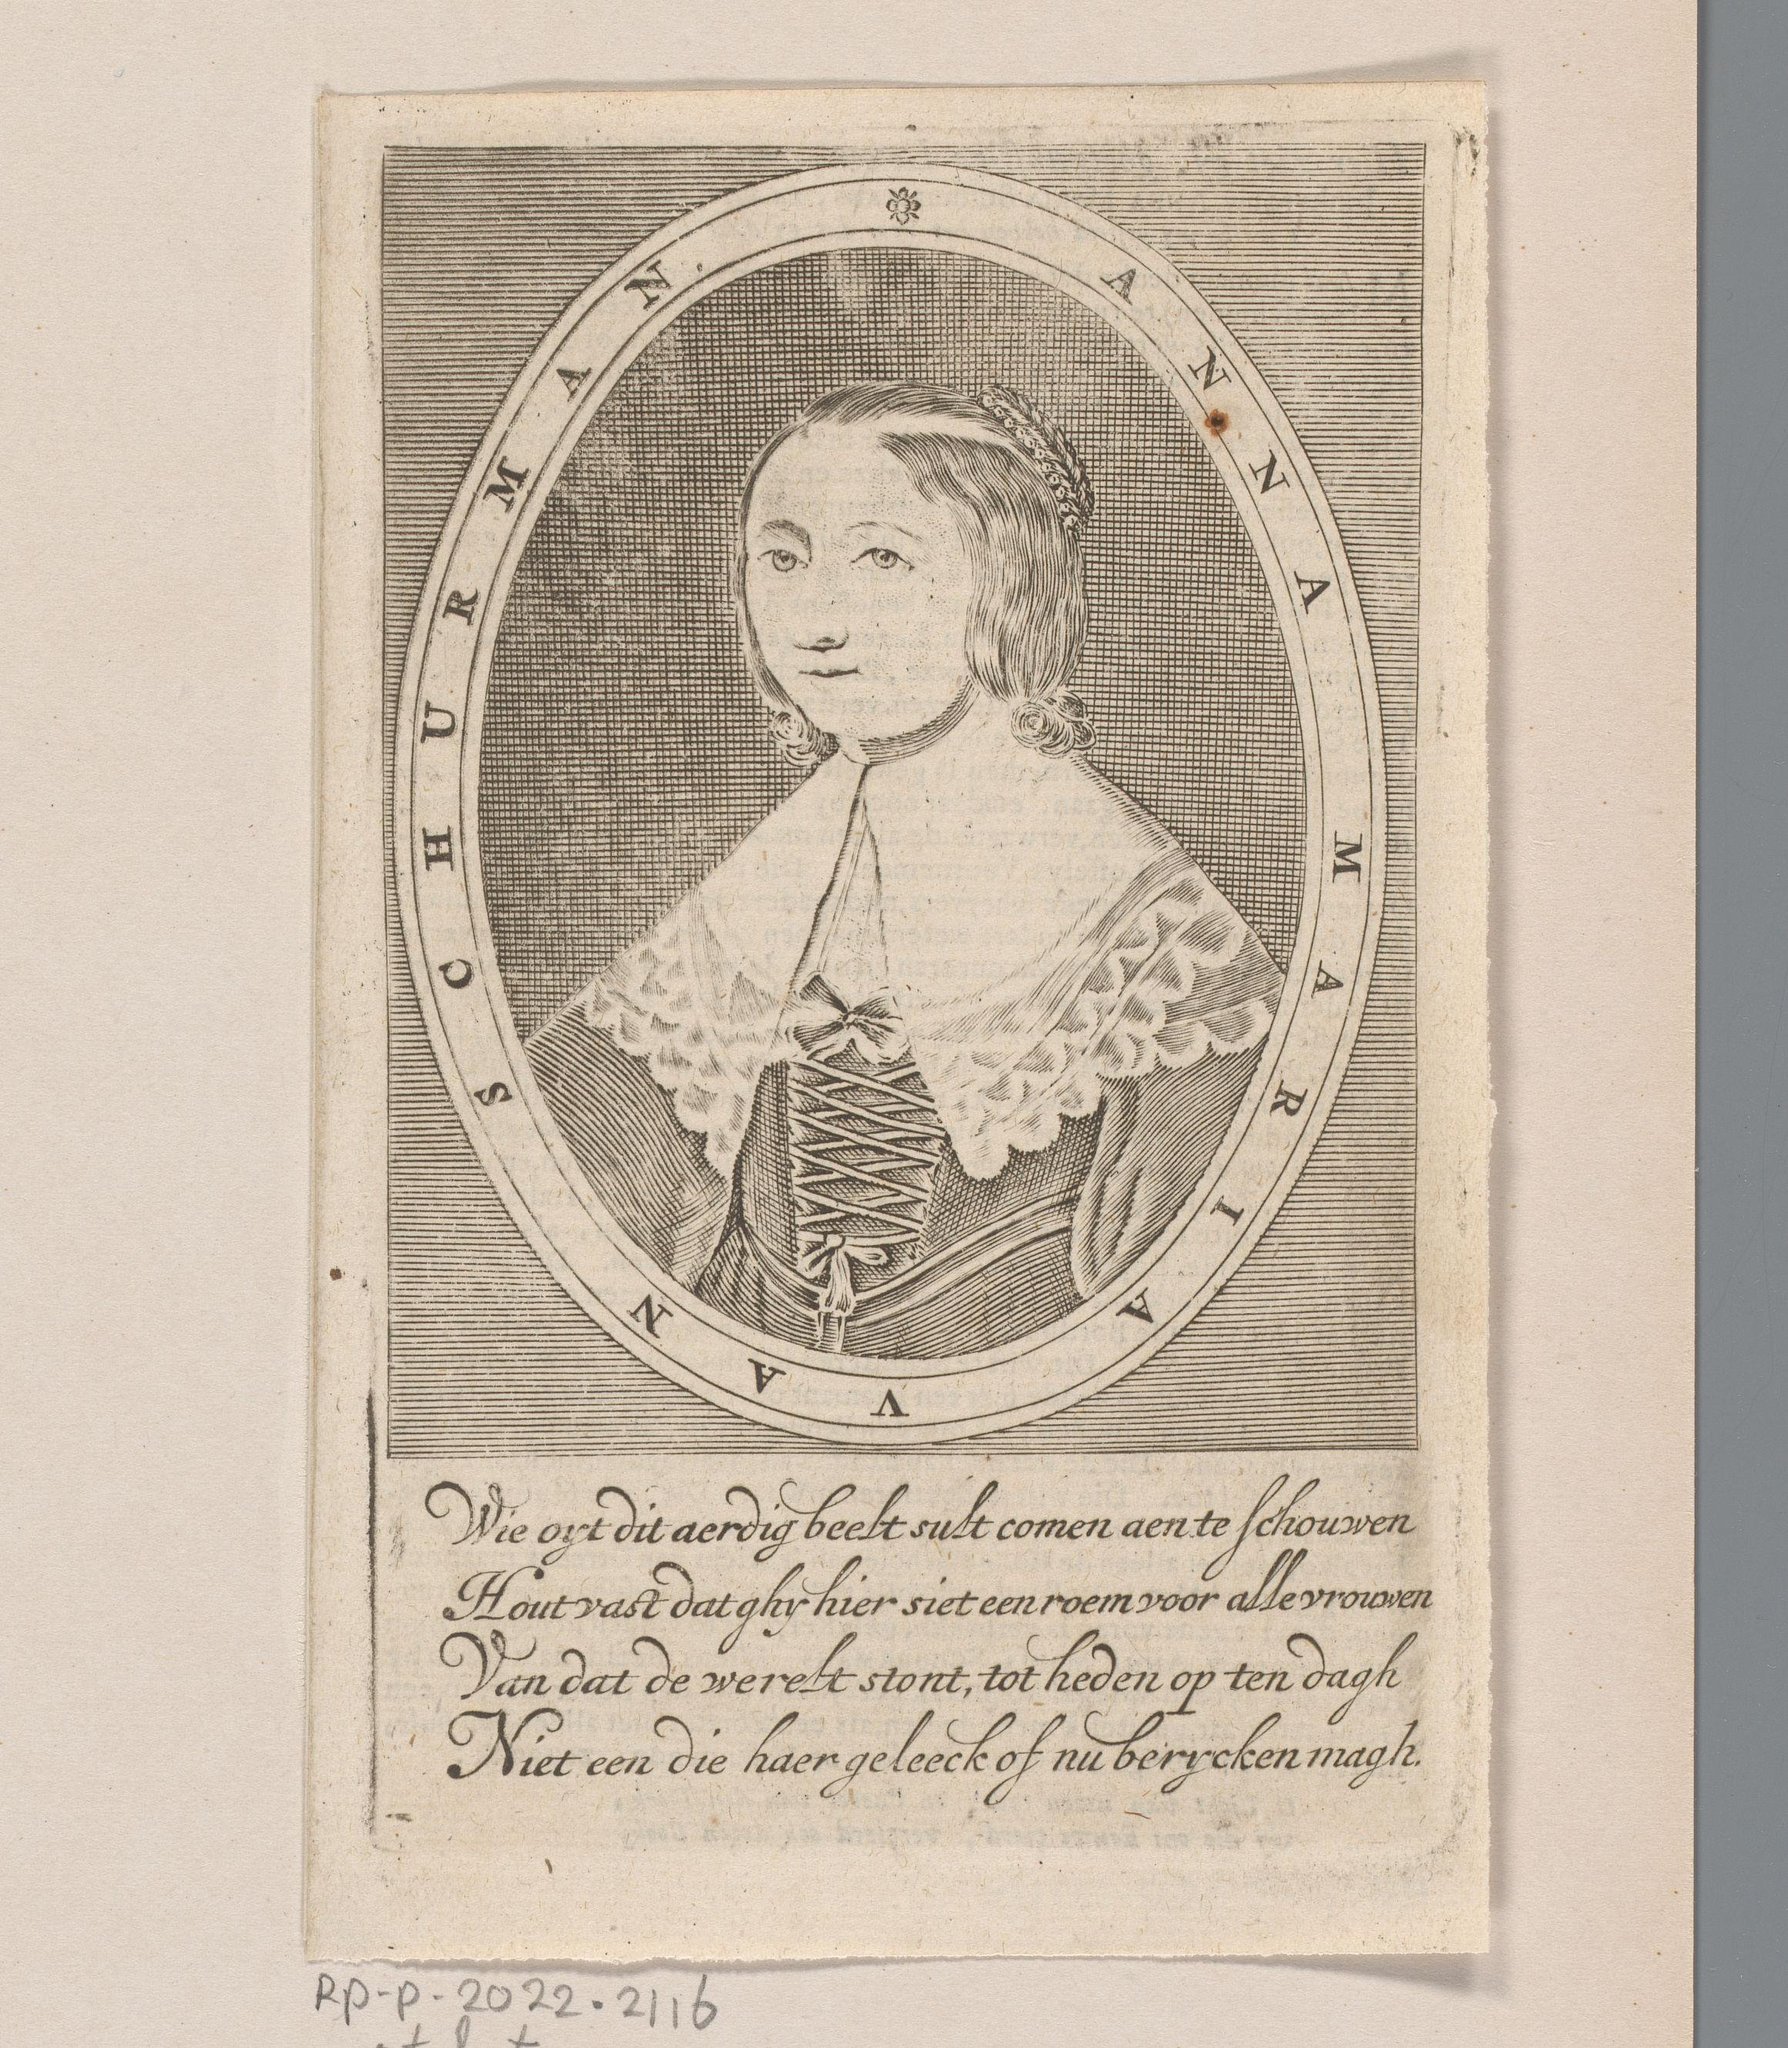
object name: print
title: Portret van Anna Maria van Schurman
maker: Anonymous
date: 1640-1799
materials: paper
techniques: engraving, letterpress printing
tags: cologne, print maker, draughtsman, anna maria van schurman, historical persons - bb - woman, portrait, self-portrait of artist, writer, poet, author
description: Met vierregelig onderschrift in het Nederlands.